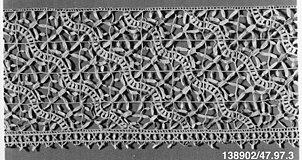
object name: border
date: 1601-1700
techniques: lace